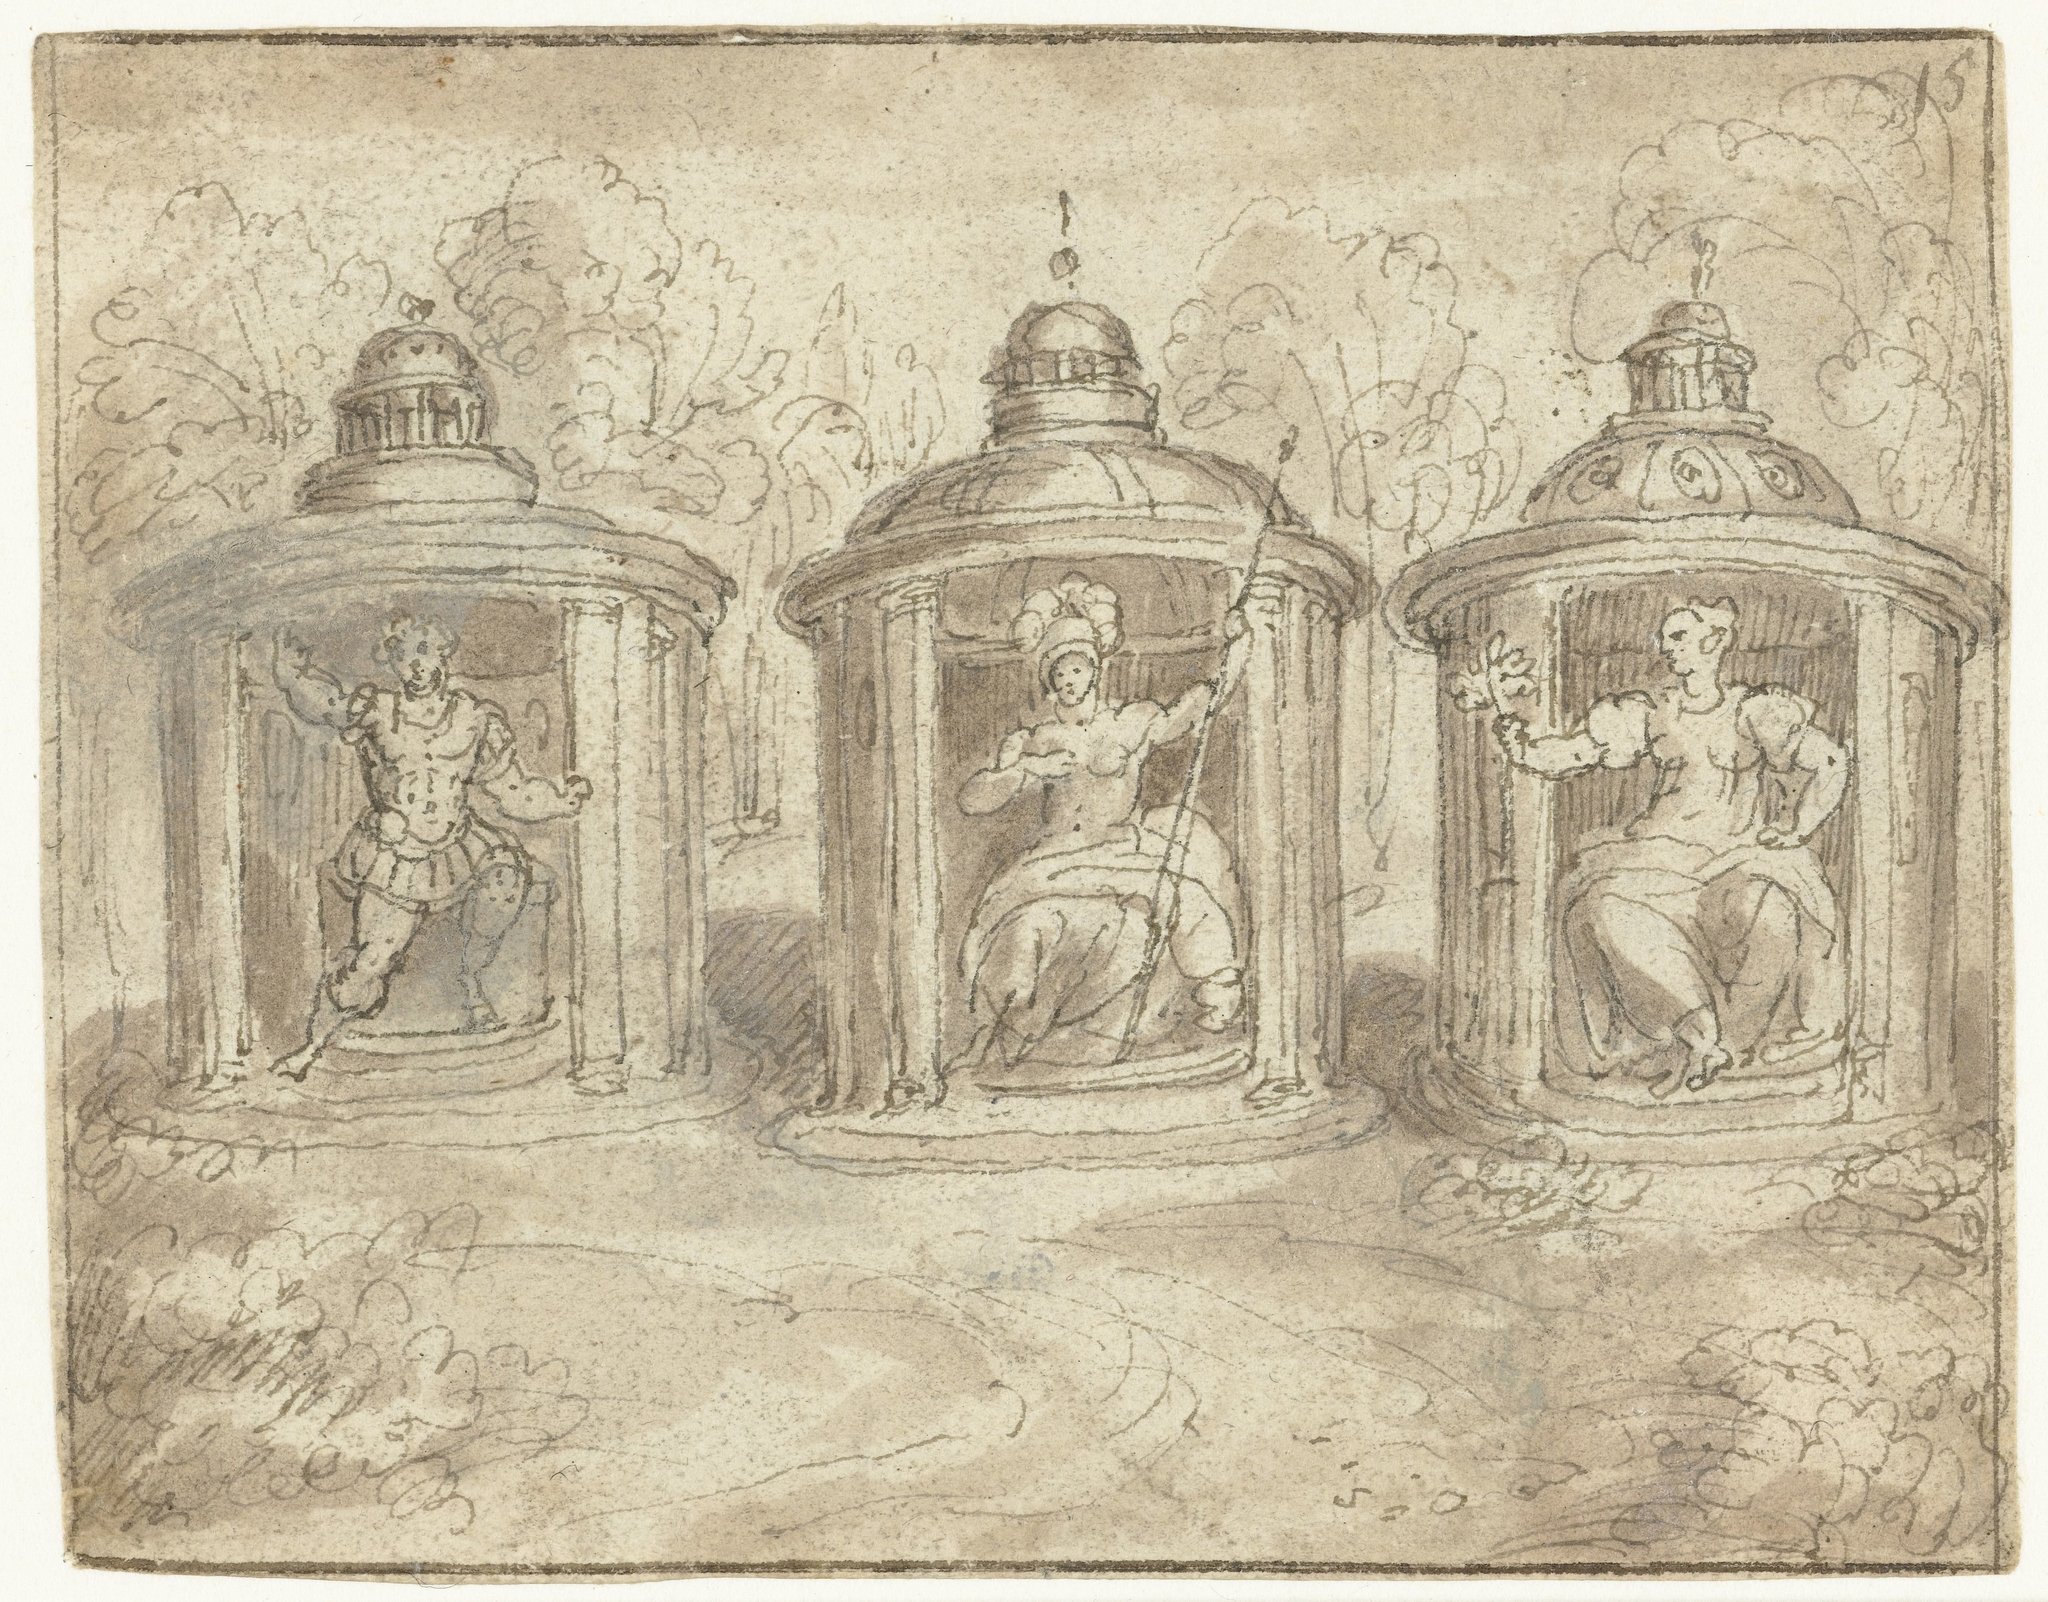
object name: design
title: Mars, Pallas Athena en Victorie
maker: jan snellinck (i)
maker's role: draughtsman, painter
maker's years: 1544-1638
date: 1575-1580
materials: ink, paper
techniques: brush, pen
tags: (story of) mars (ares)